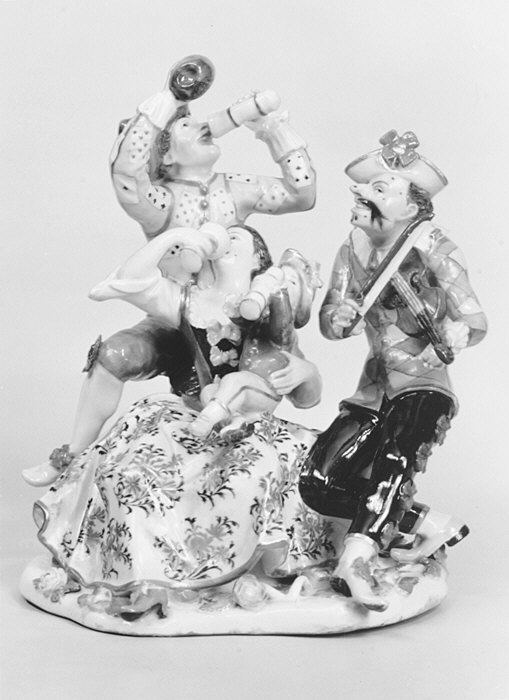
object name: group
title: Drinking harlequin family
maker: meissen manufactory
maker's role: manufactory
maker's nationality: german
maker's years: 1710-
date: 1745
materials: hard paste porcelain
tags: men,drinking